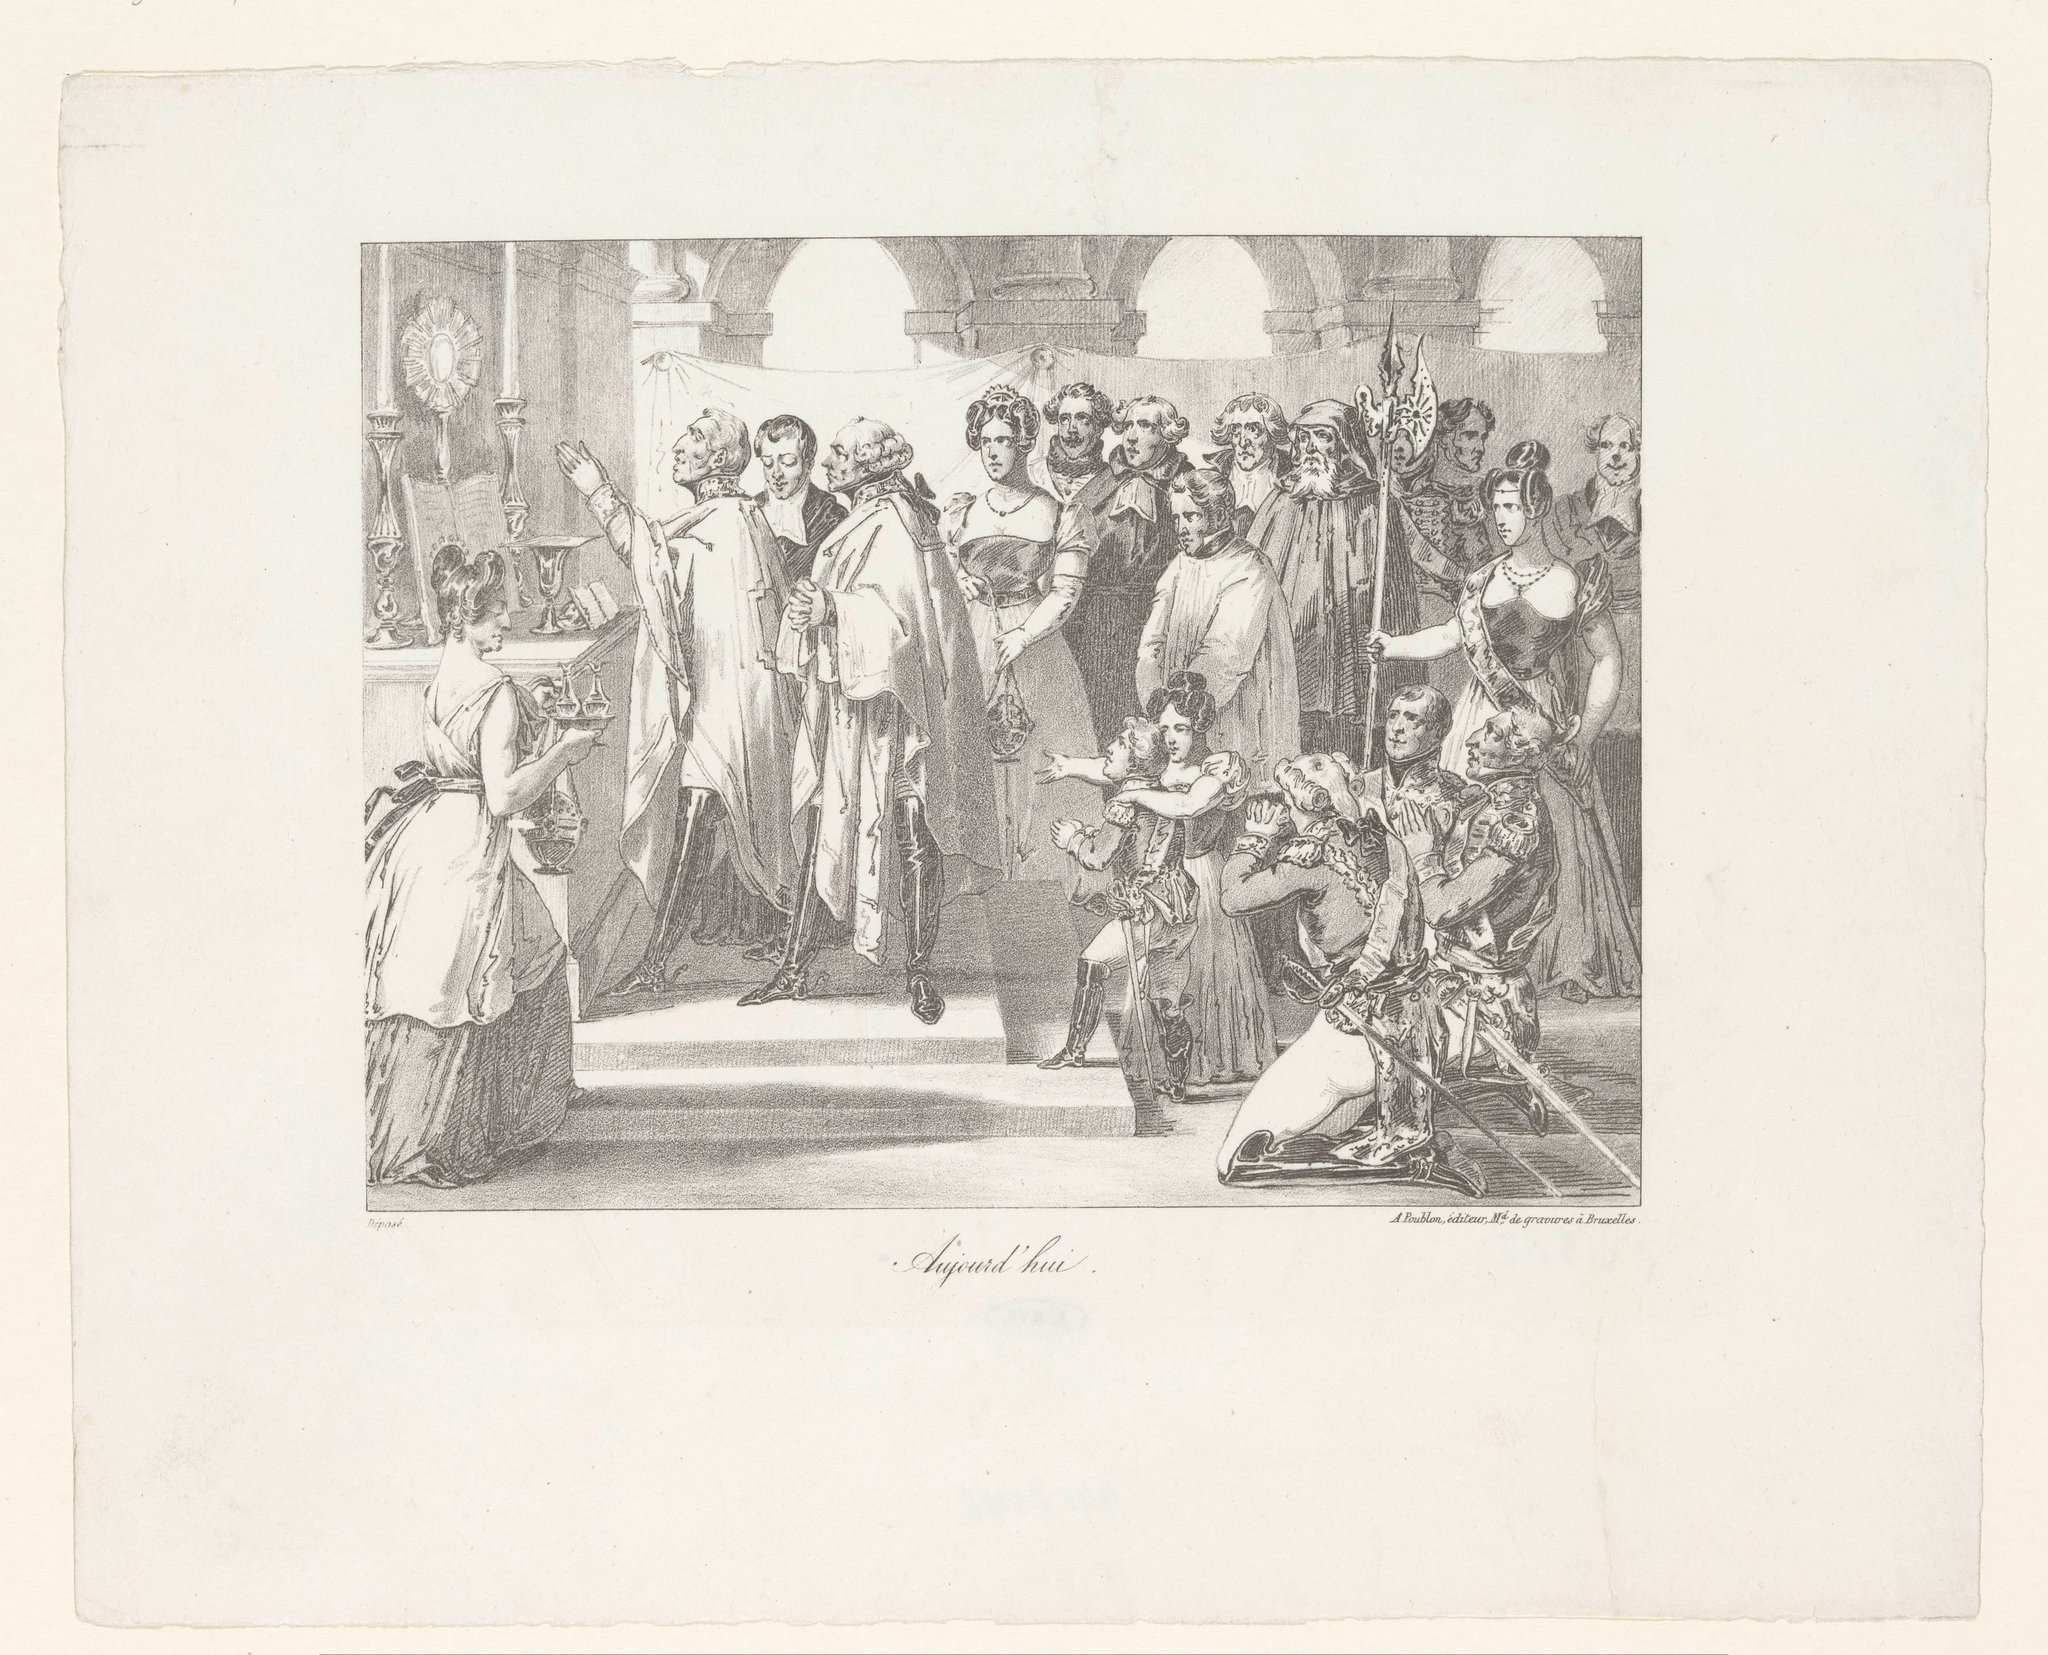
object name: print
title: Vandaag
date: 1825-1830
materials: paper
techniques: lithograph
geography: brussels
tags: holy mass (divine service, especially of roman catholic church), dissimulation, hypocrisy; 'hippocresia', 'simulatione' (ripa)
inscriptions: collector's mark: Lugt 2228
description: Koning Karel X van Frankrijk leidt als priester de mis. Spotprent op zijn hypcriete gedrag. Zie ook de pendant. Ca. 1830.